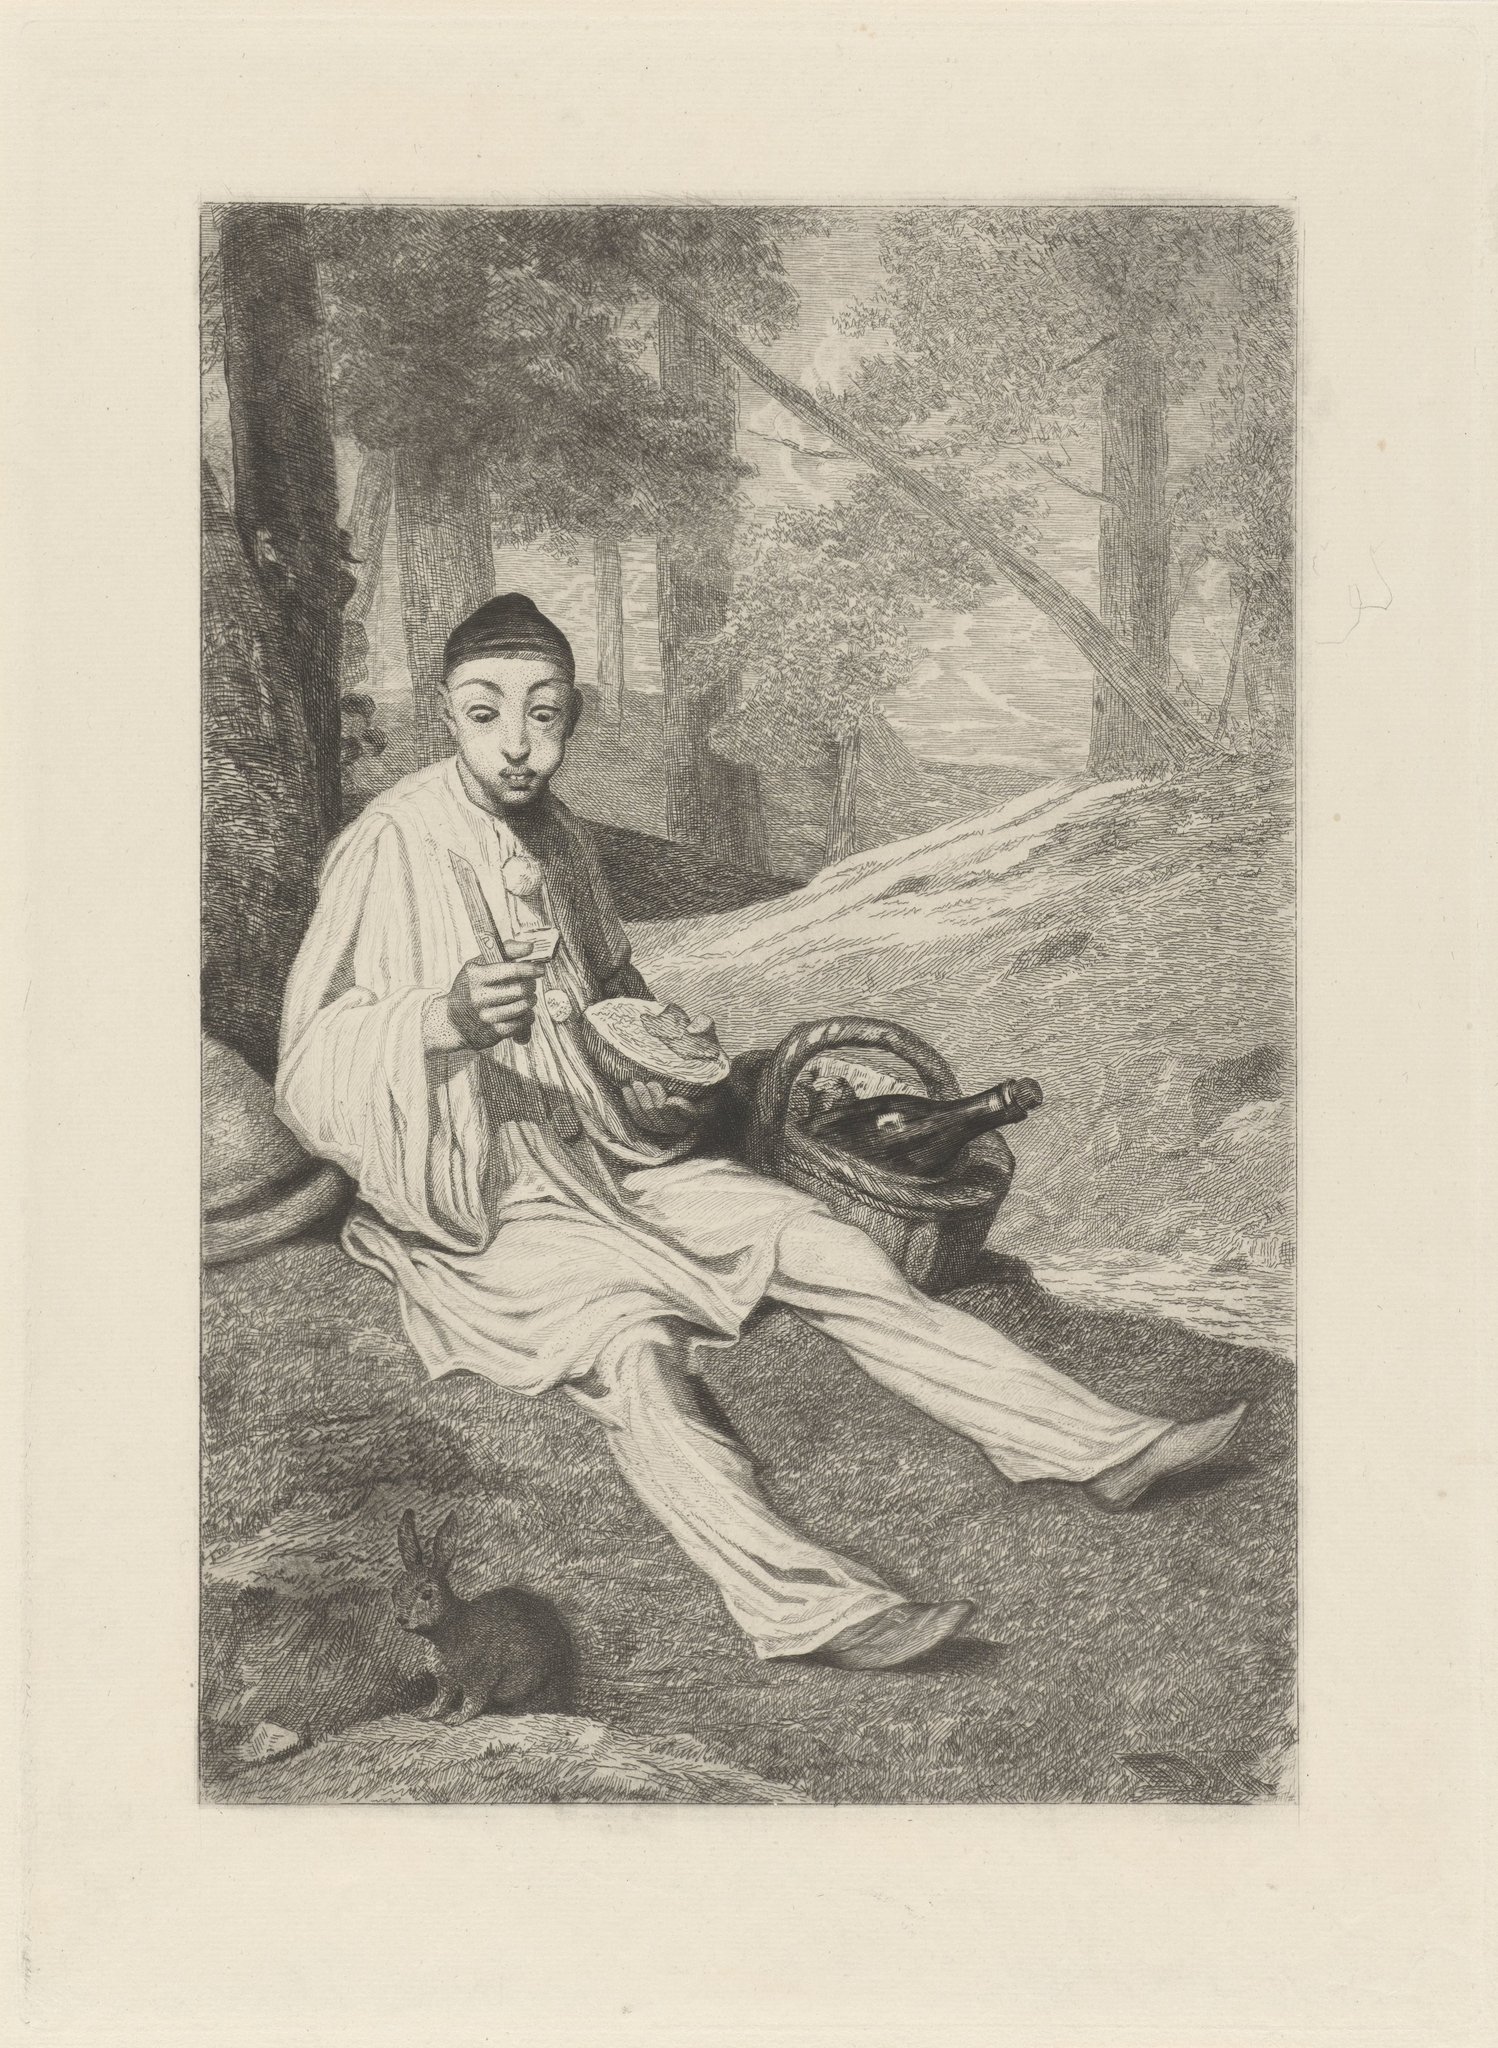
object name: print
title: Pierrot en een konijn in een landschap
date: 1851-1893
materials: paper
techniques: etching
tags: types in 'commedia dell'arte': pierrot, forest, wood, rodents: rabbit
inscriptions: collector's mark: Lugt 2228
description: In een bosrijk landschap zit een pierrot met brood en een mes in zijn handen, naast hem staat een hengselmand met een fles drank. De pierrot kijkt op naar een konijn die voor hem uit de grond tevoorschijn is gekomen.